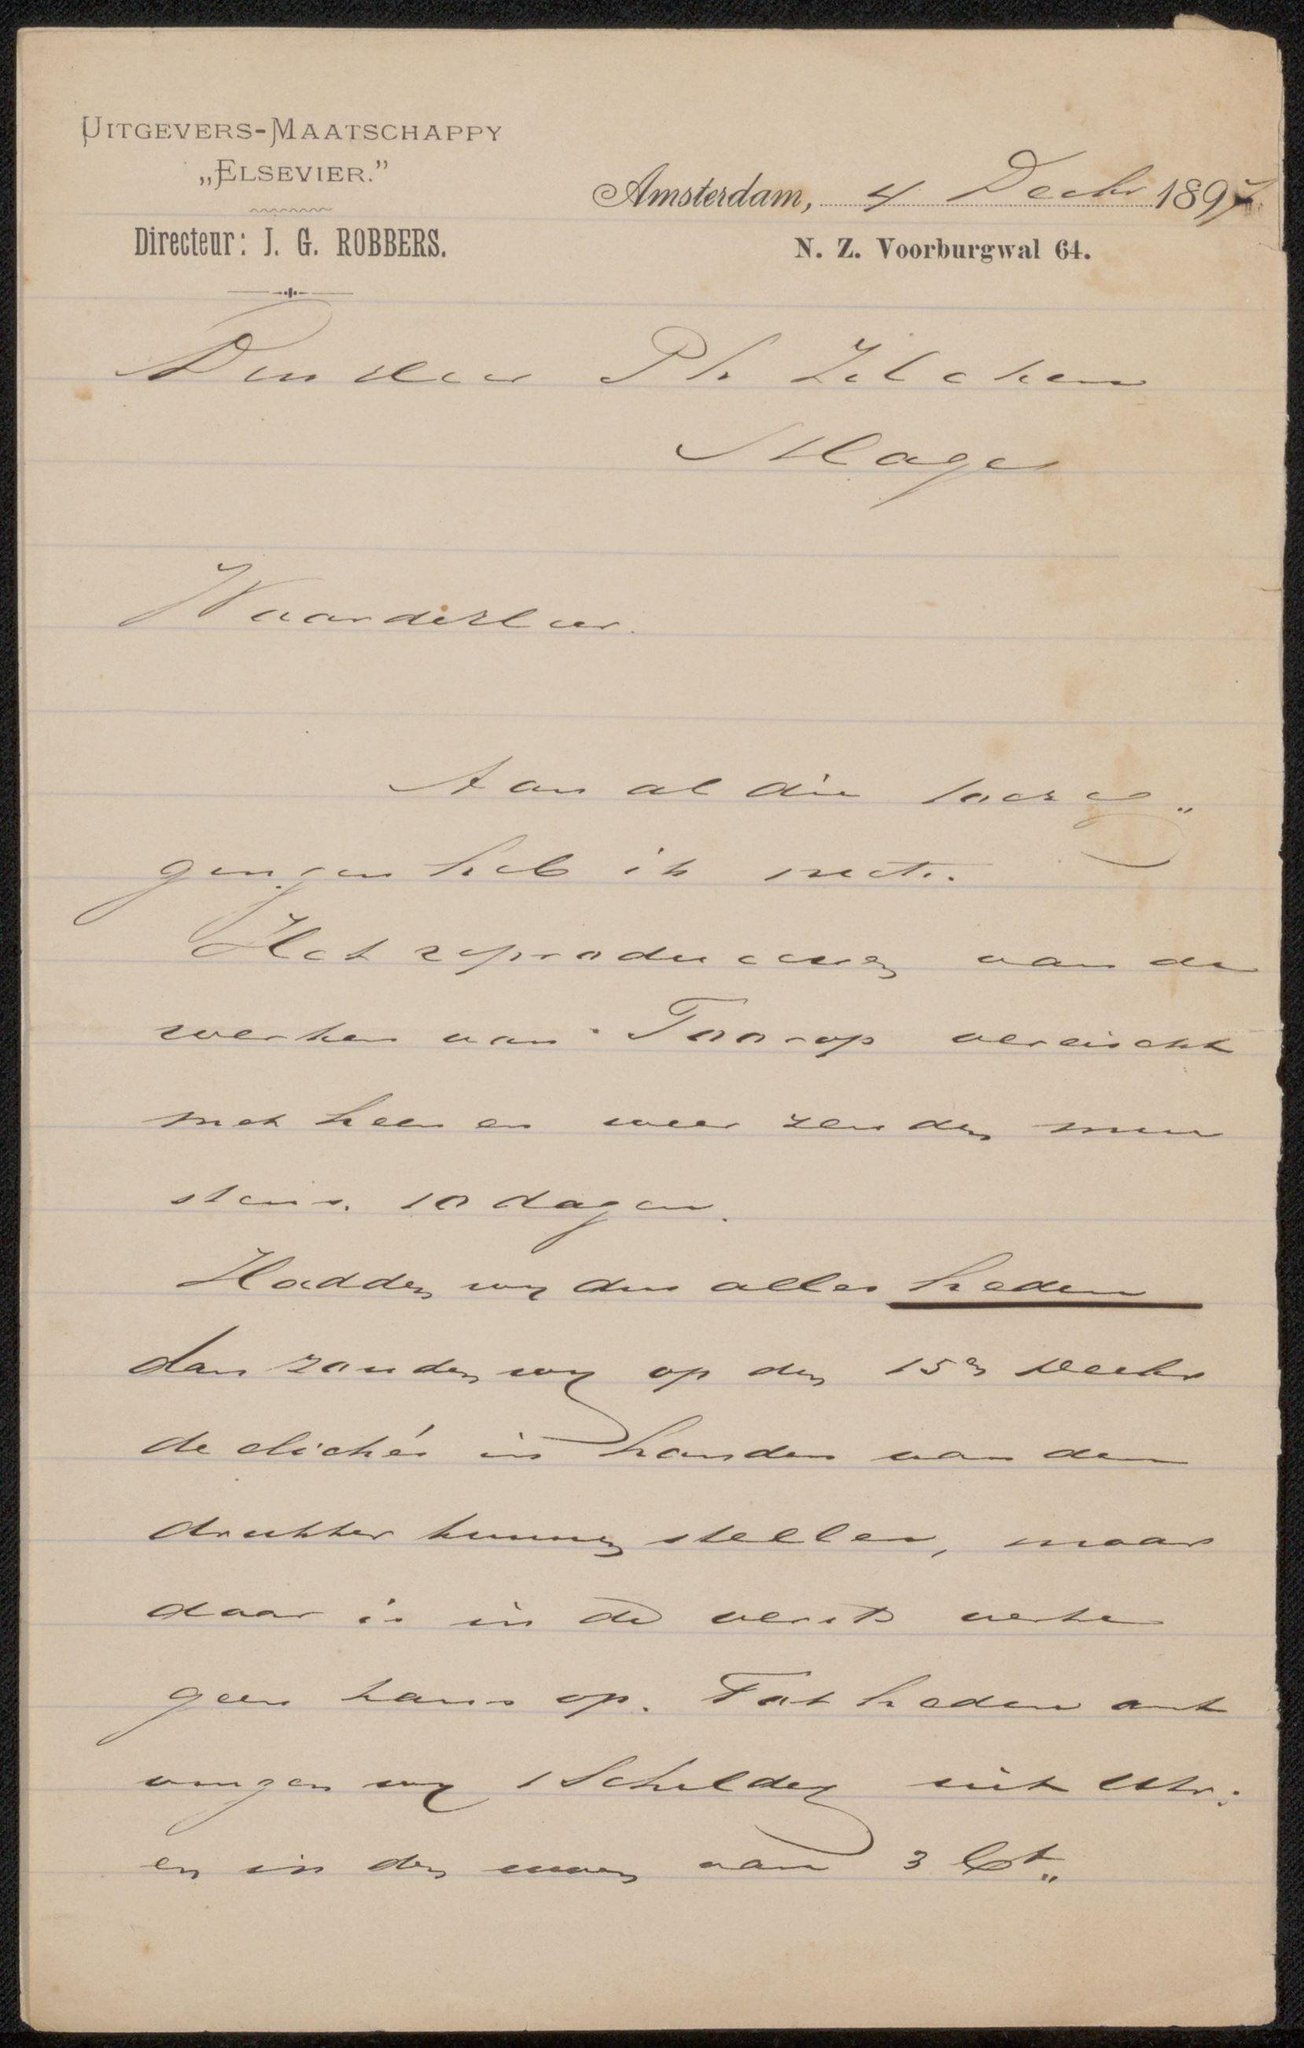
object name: letter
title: Brief aan Philip Zilcken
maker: jacobus george robbers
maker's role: publisher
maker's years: 1838-1925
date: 1897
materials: ink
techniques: pen, printing, writing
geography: amsterdam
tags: marinus van der maarel, amsterdam, the hague, print maker, draughtsman, hendrik johannes haverman, painter, jan toorop, philip zilcken, painting (including book-illumination, miniature-painting), historical persons (portraits and scenes from the life), utrecht, paris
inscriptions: name: ‘DE UITGEVERS-MAATSCHAPPIJ ,,ELSEVIER''.’, collector's mark: ‘RPK’